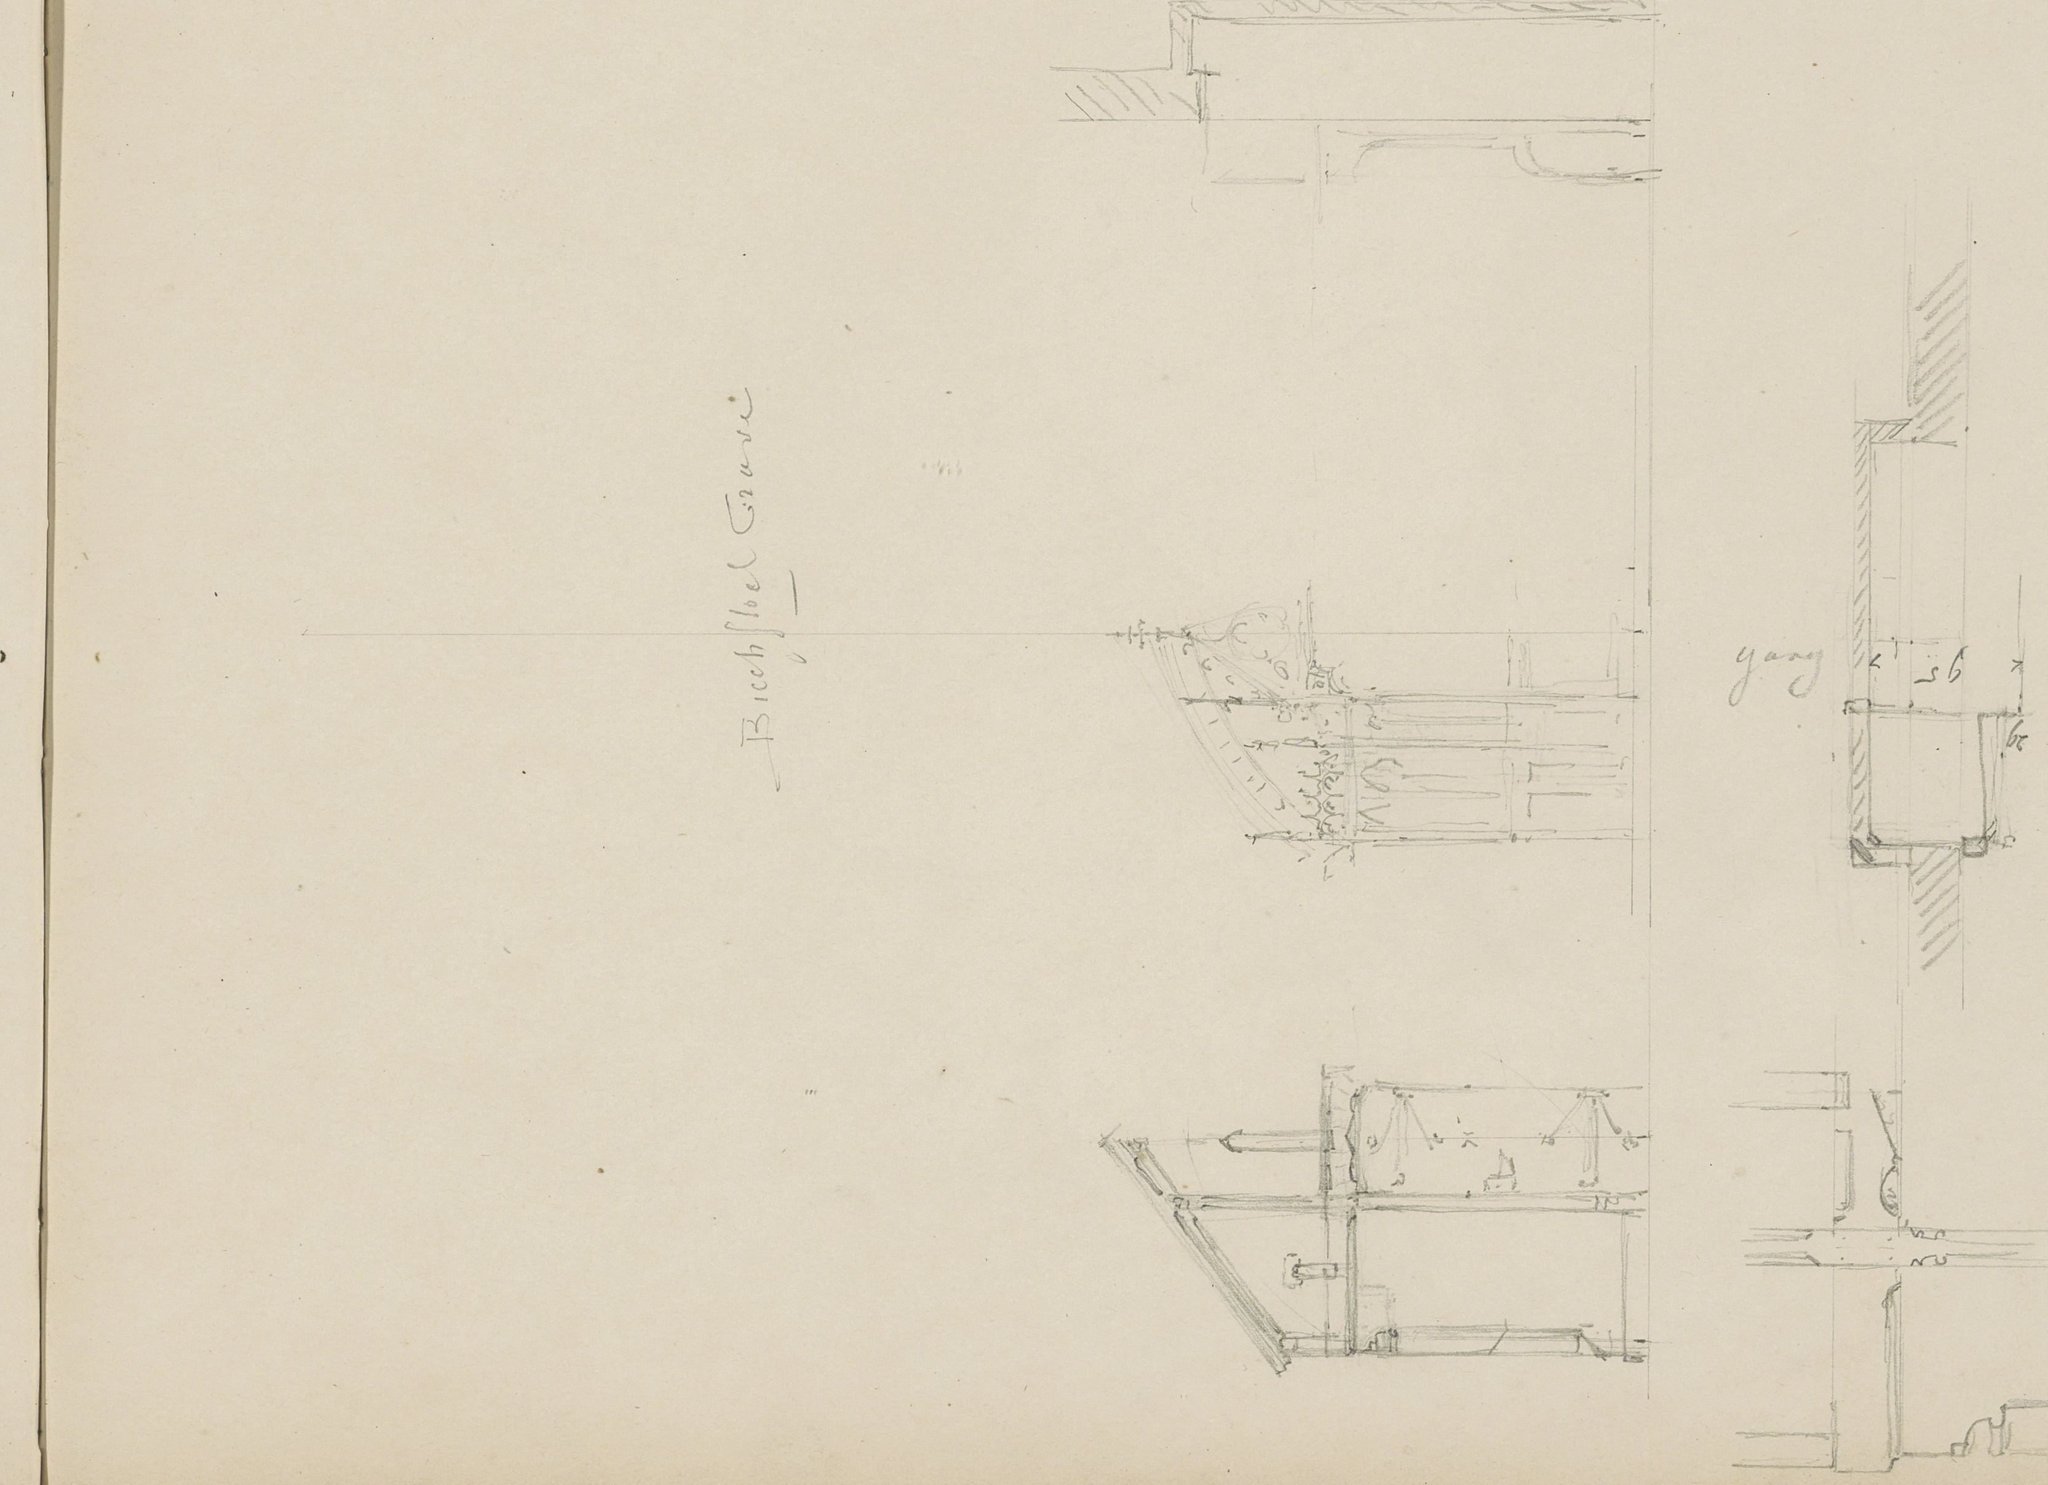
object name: sketchbook leaf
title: Biechtstoel, Grave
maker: pierre joseph hubert cuypers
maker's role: draughtsman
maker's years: 1827-1921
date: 1857-1859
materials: paper, pencil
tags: confessional ~ part of the confession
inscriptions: annotation: ‘Biechtstoel Grave/ gang kapel’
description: Tevens een plattegrond van een gangkapel. Blad 60 recto uit een schetsboek met 77 bladen.